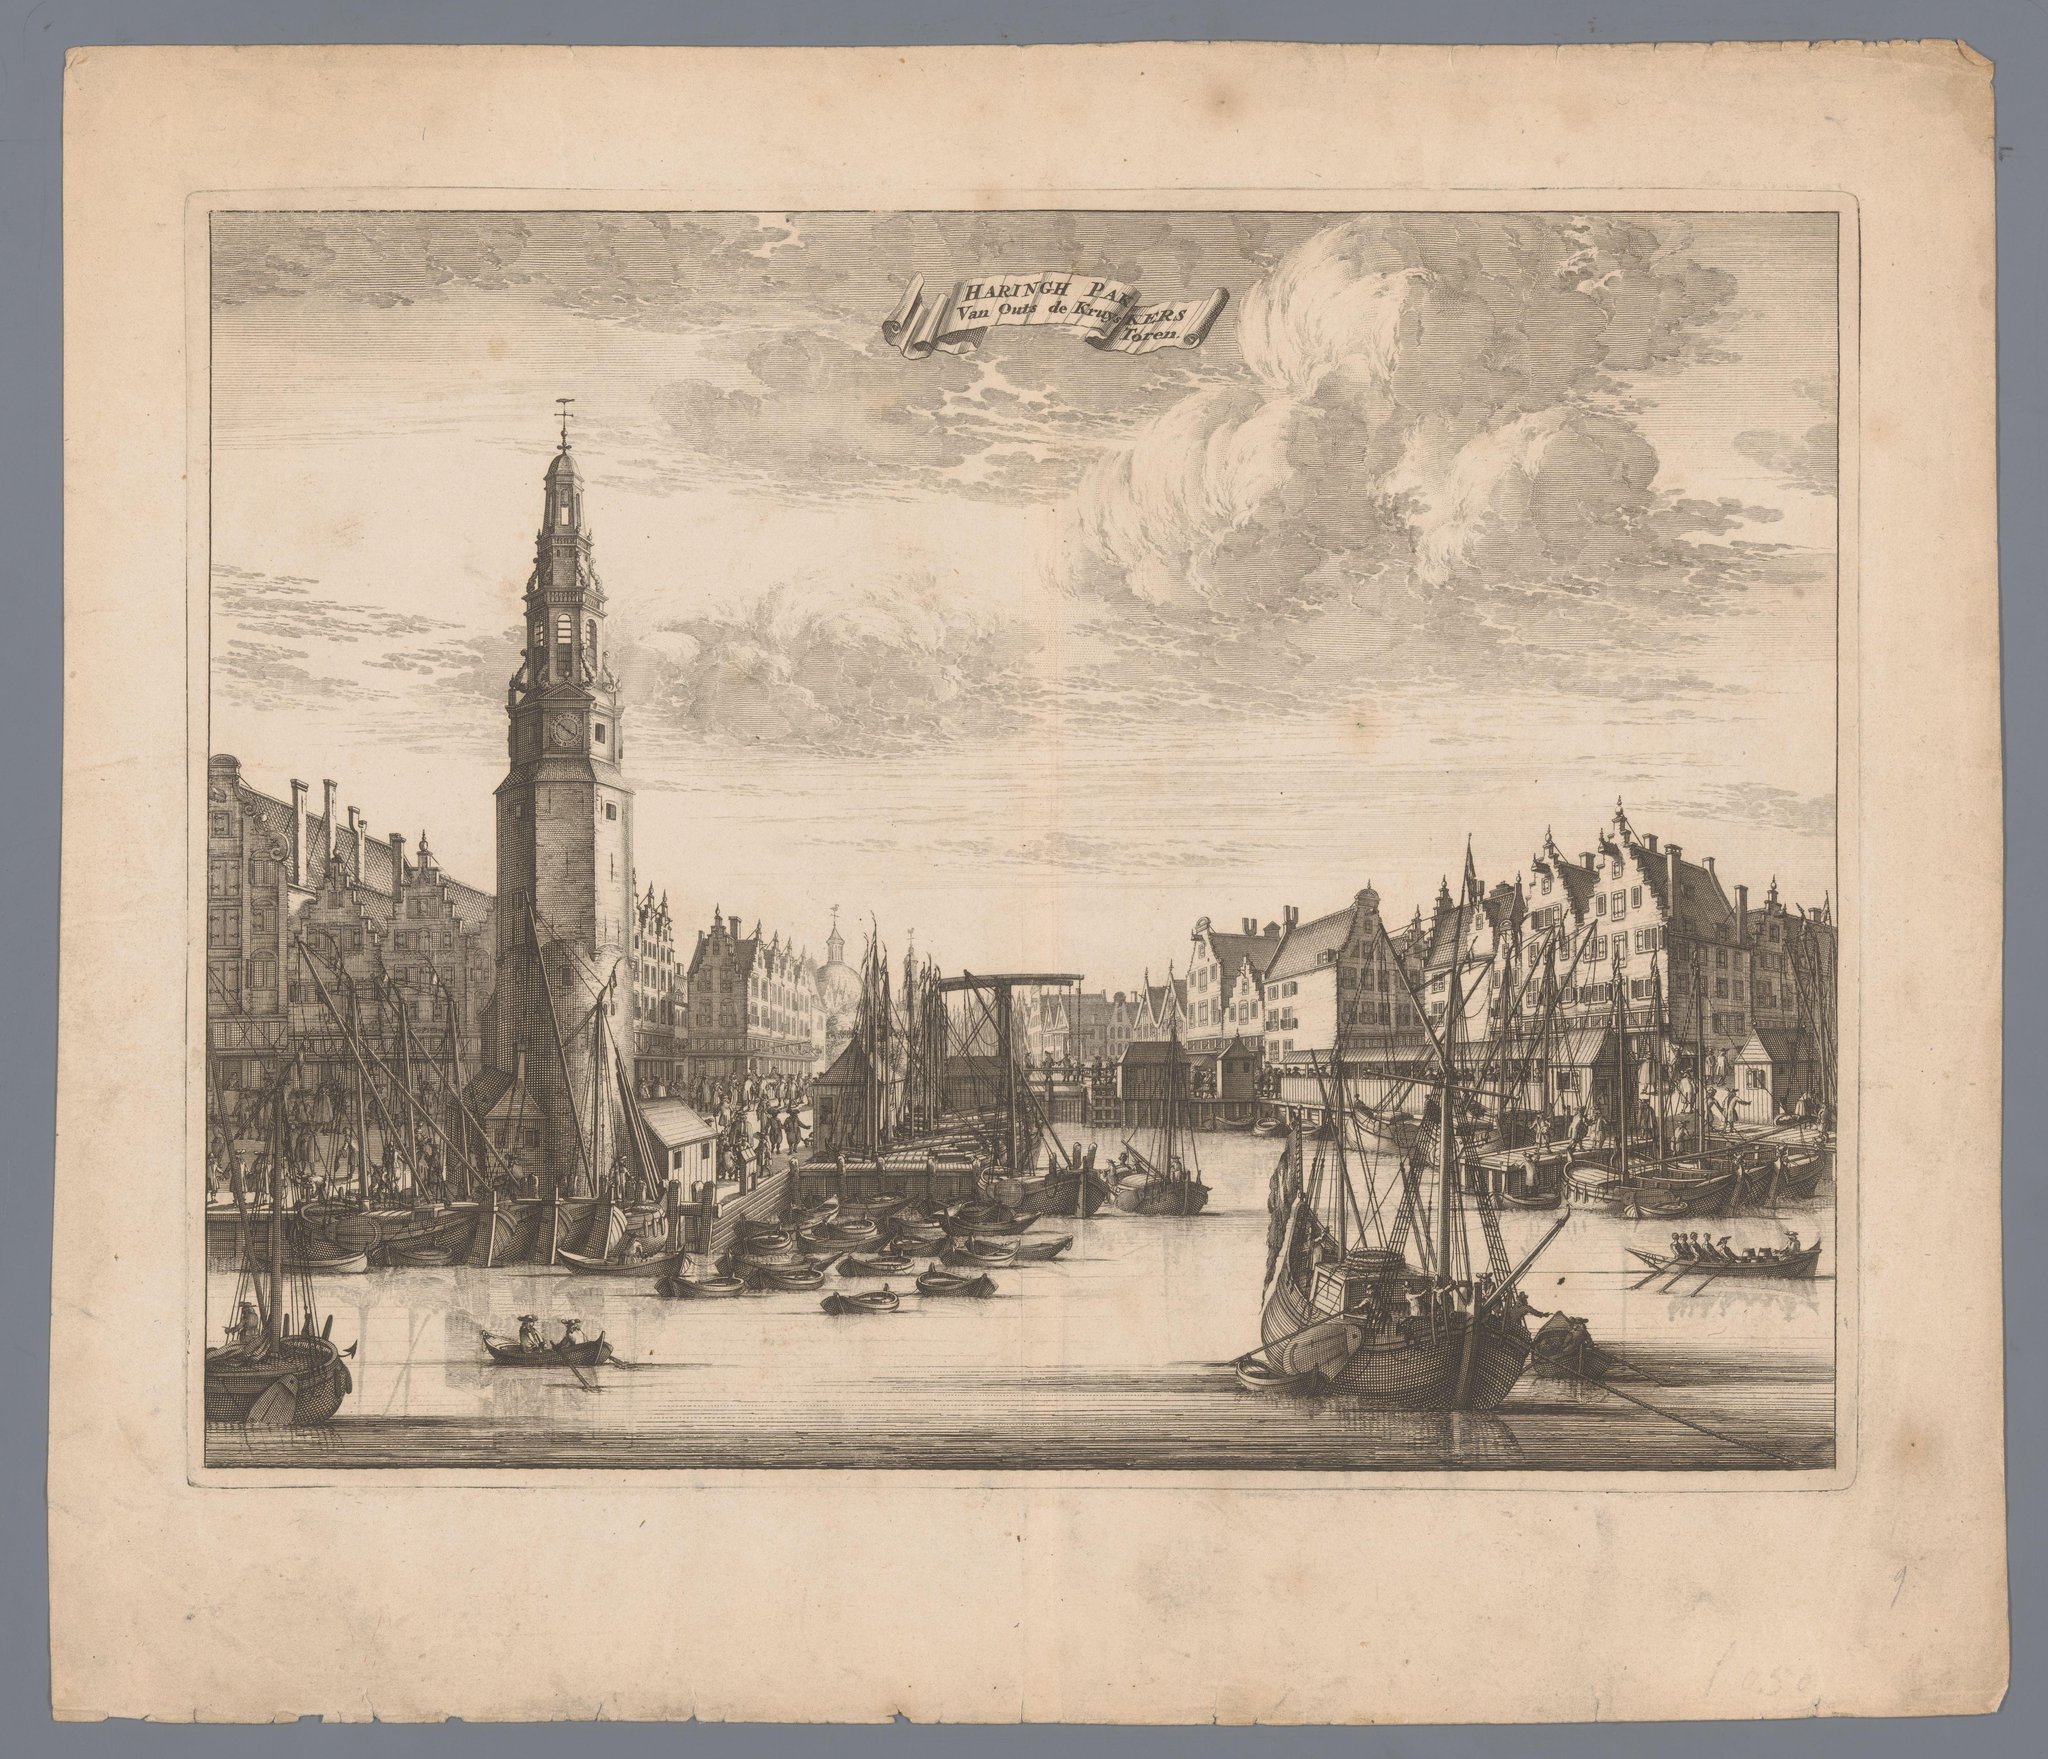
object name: print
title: Gezicht op de Haringpakkerstoren te Amsterdam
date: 1693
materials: paper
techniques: etching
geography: amsterdam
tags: tower, clock tower ~ monumental adornment, canals, waters (in city) (+ city(-scape) with figures, staffage)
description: Prent uit: Commelin, Caspar. Beschryvinge van Amsterdam, desselfs eerste oorspronk uyt den Huyse (…). Amsterdam: Abraham Wolfgang et al., 1693. Of uit: Commelin, Caspar. Beschryvinge van Amsterdam, zynde een naukeurige verhandelinge van desselfs eerste oorspronk uyt (…). Amsterdam: weduwe Aart Dircksz Oossaan, 1694. Latere staat gebruikt in: Commelin, Caspar. Beschryvinge van Amsterdam, zynde een naukeurige verhandelinge van desselfs eerste oorspronk uyt (…). Amsterdam: Andries van Damme et al., 1726.